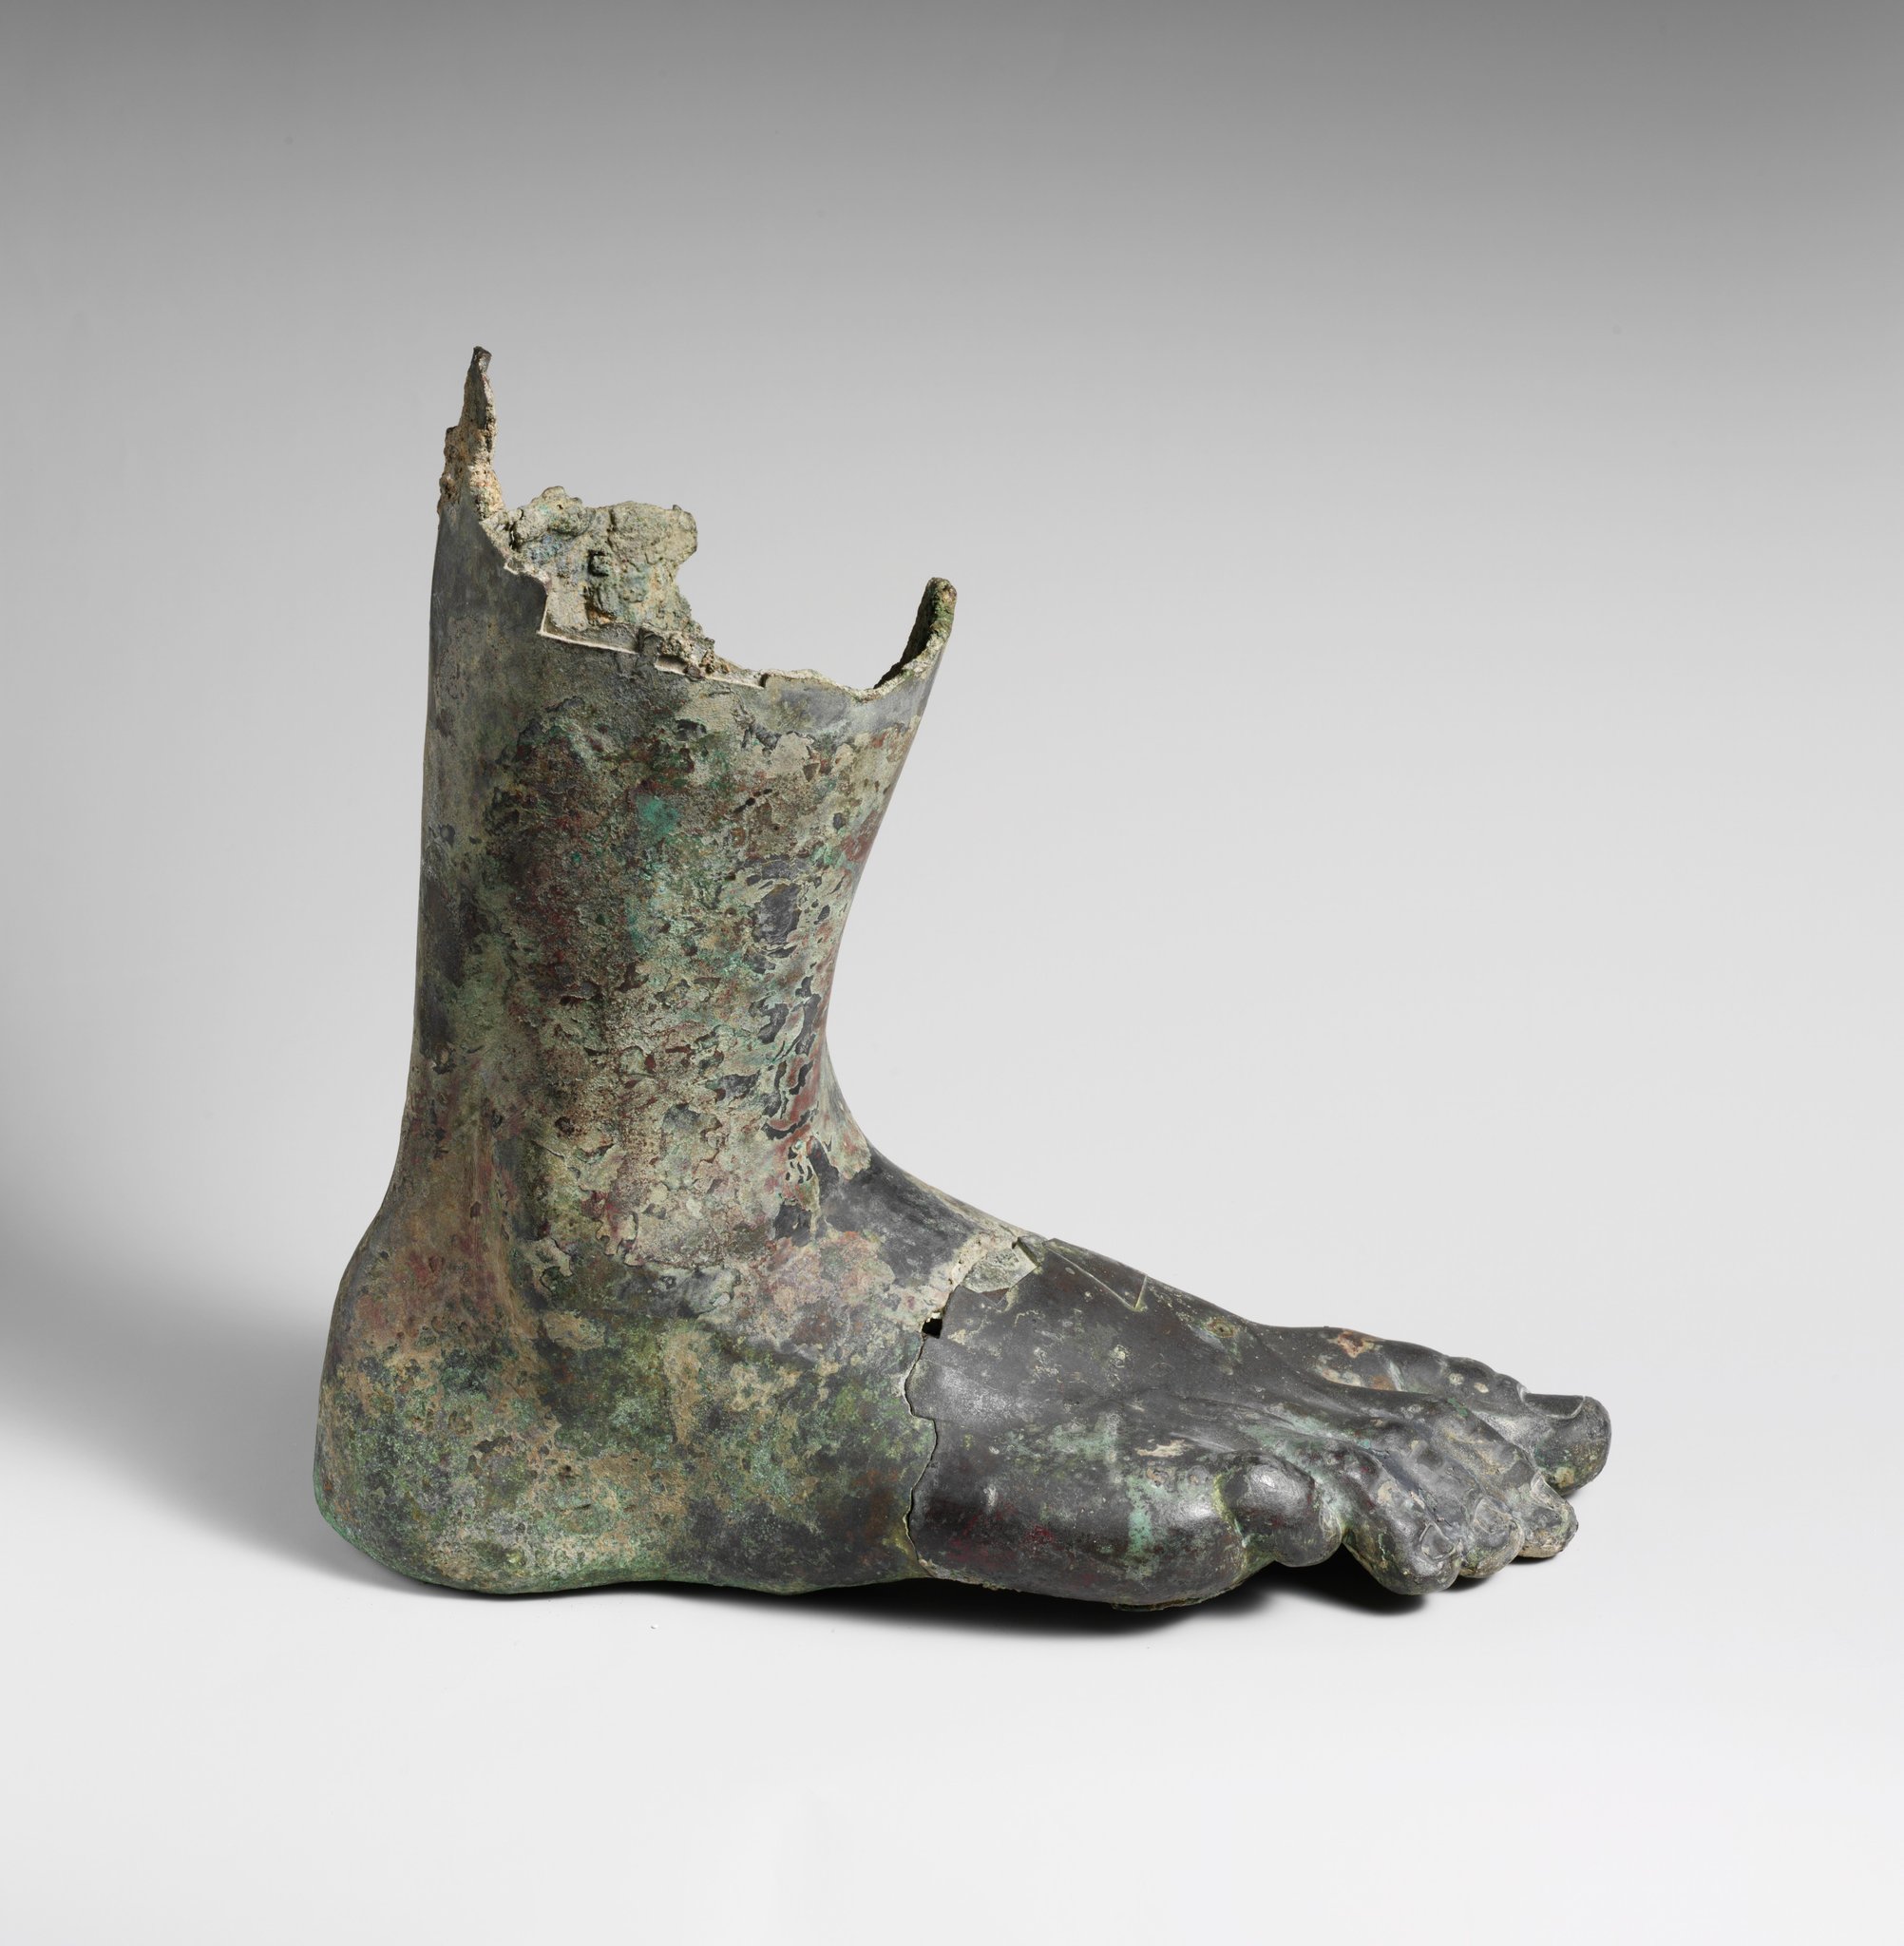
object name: foot fragment, colossal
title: Bronze right foot and lower leg from a colossal statue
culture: roman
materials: bronze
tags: feet